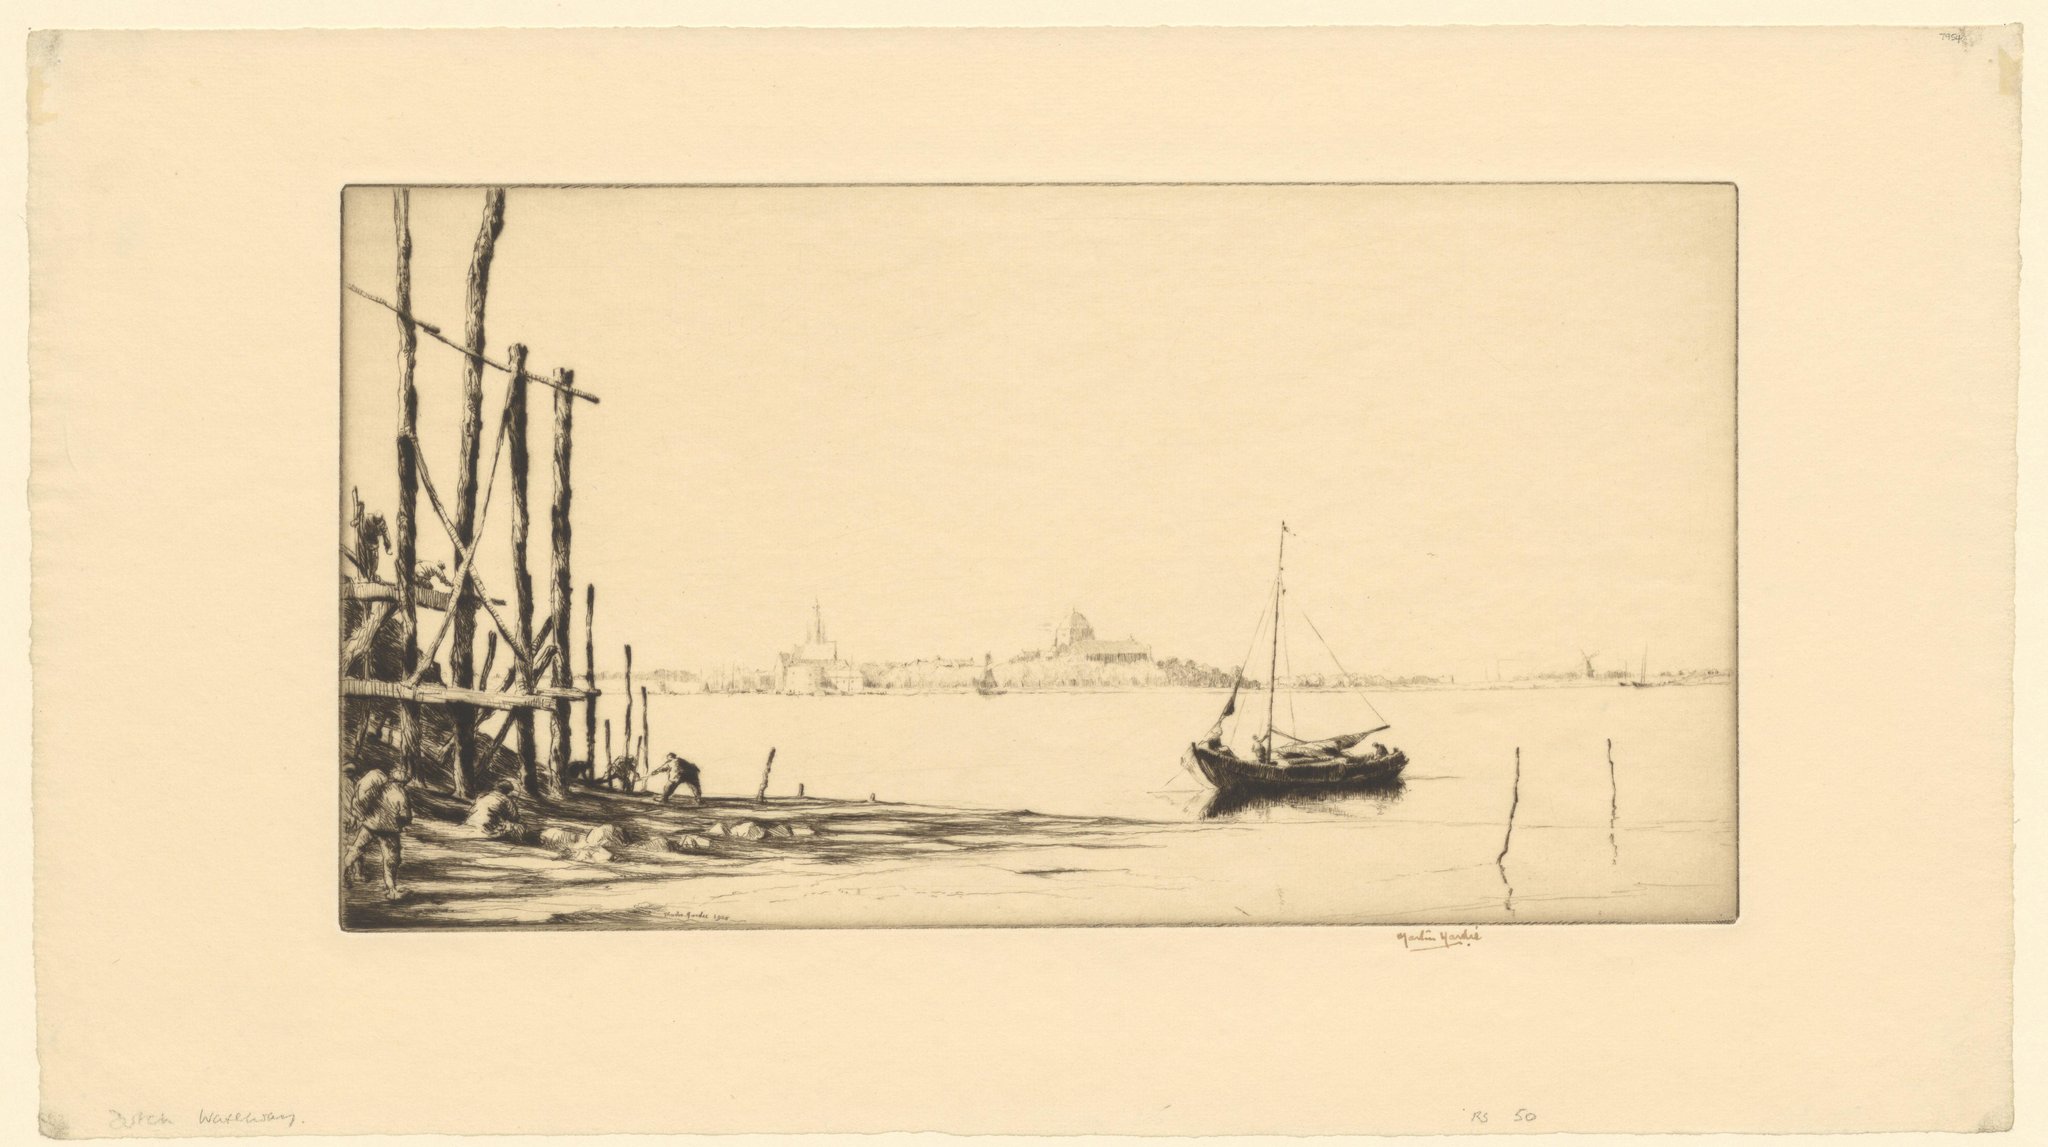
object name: print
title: Gezicht op Veere over het Veerse Meer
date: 1926-1927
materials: paper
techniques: drypoint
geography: veere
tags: lake (+ landscape with figures, staffage), city-view in general; 'veduta' (+ city(-scape) with figures, staffage)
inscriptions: collector's mark: Lugt 2228, annotation: ‘Martin Hardie’, collector's mark: Lugt 2760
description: Volgens de notities in de catalogus maakte Hardie de schetsen voor deze prent op de boot van James McBey. De kerk en klokkentoren zijn in de prent verkeerd om weergegeven.